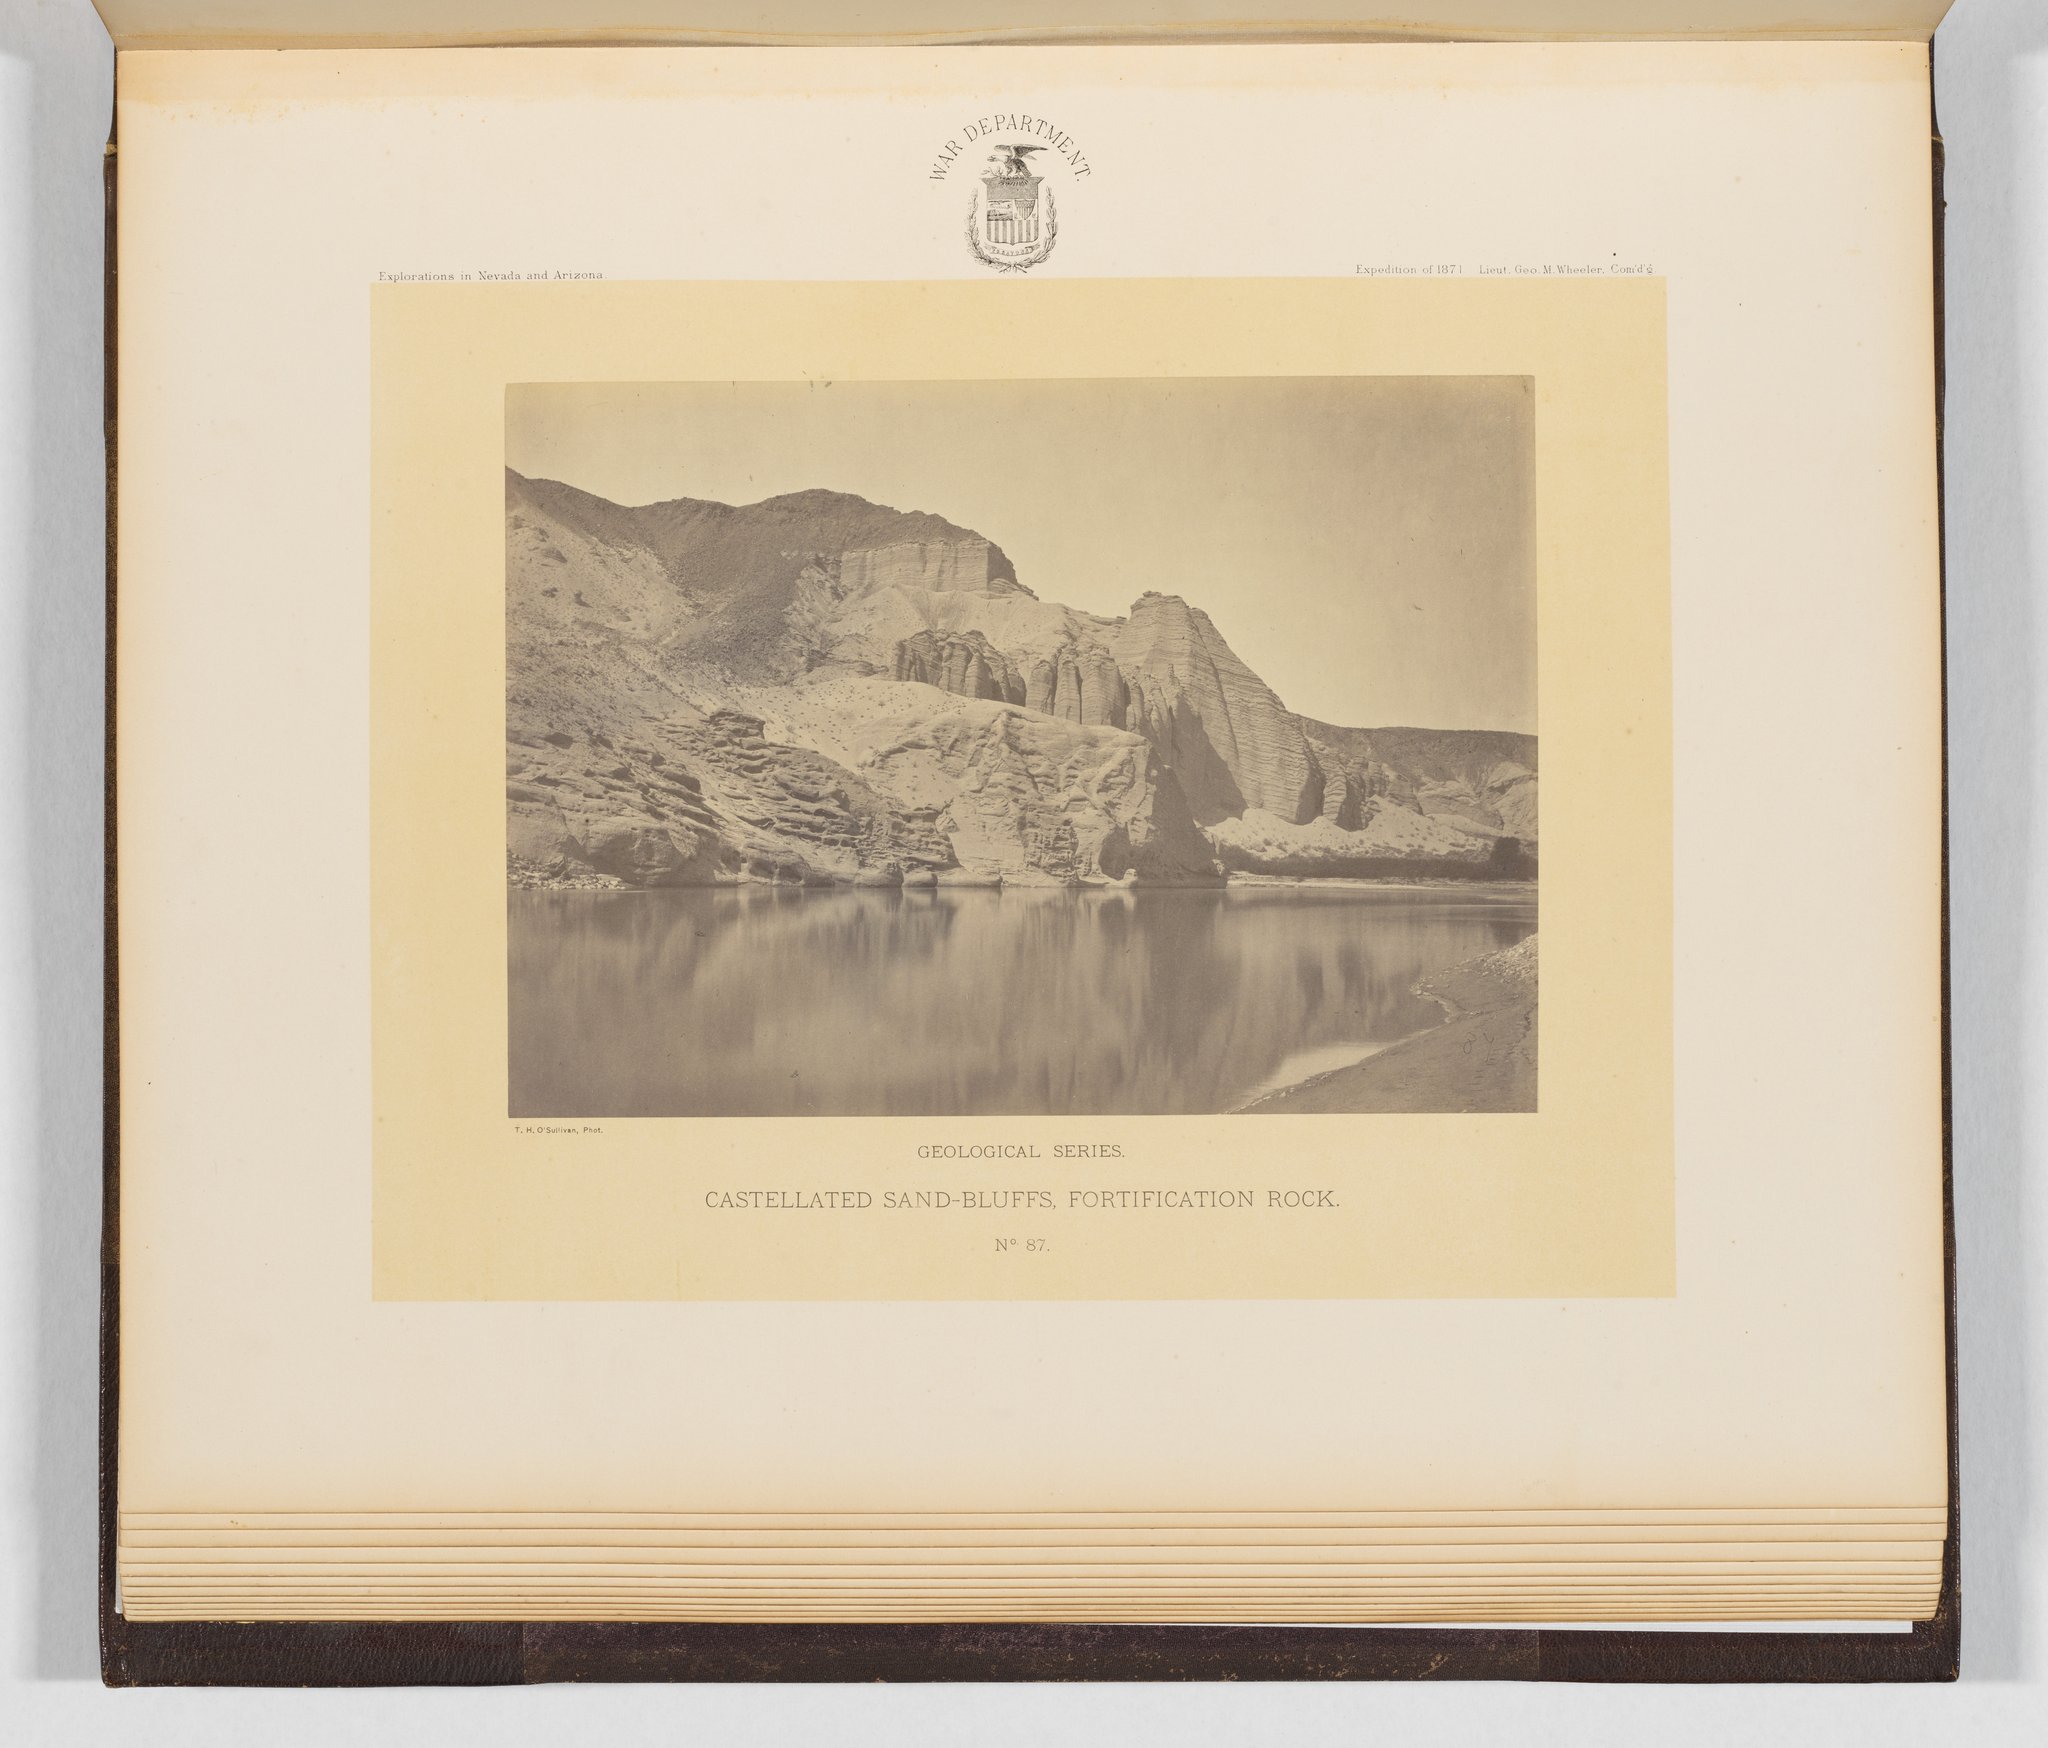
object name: photograph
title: Castellated Sand-Bluffs, Fortification Rock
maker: timothy h. o'sullivan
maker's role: artist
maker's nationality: american, born ireland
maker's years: 1840-1882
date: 1871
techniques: albumen silver print, glass negative